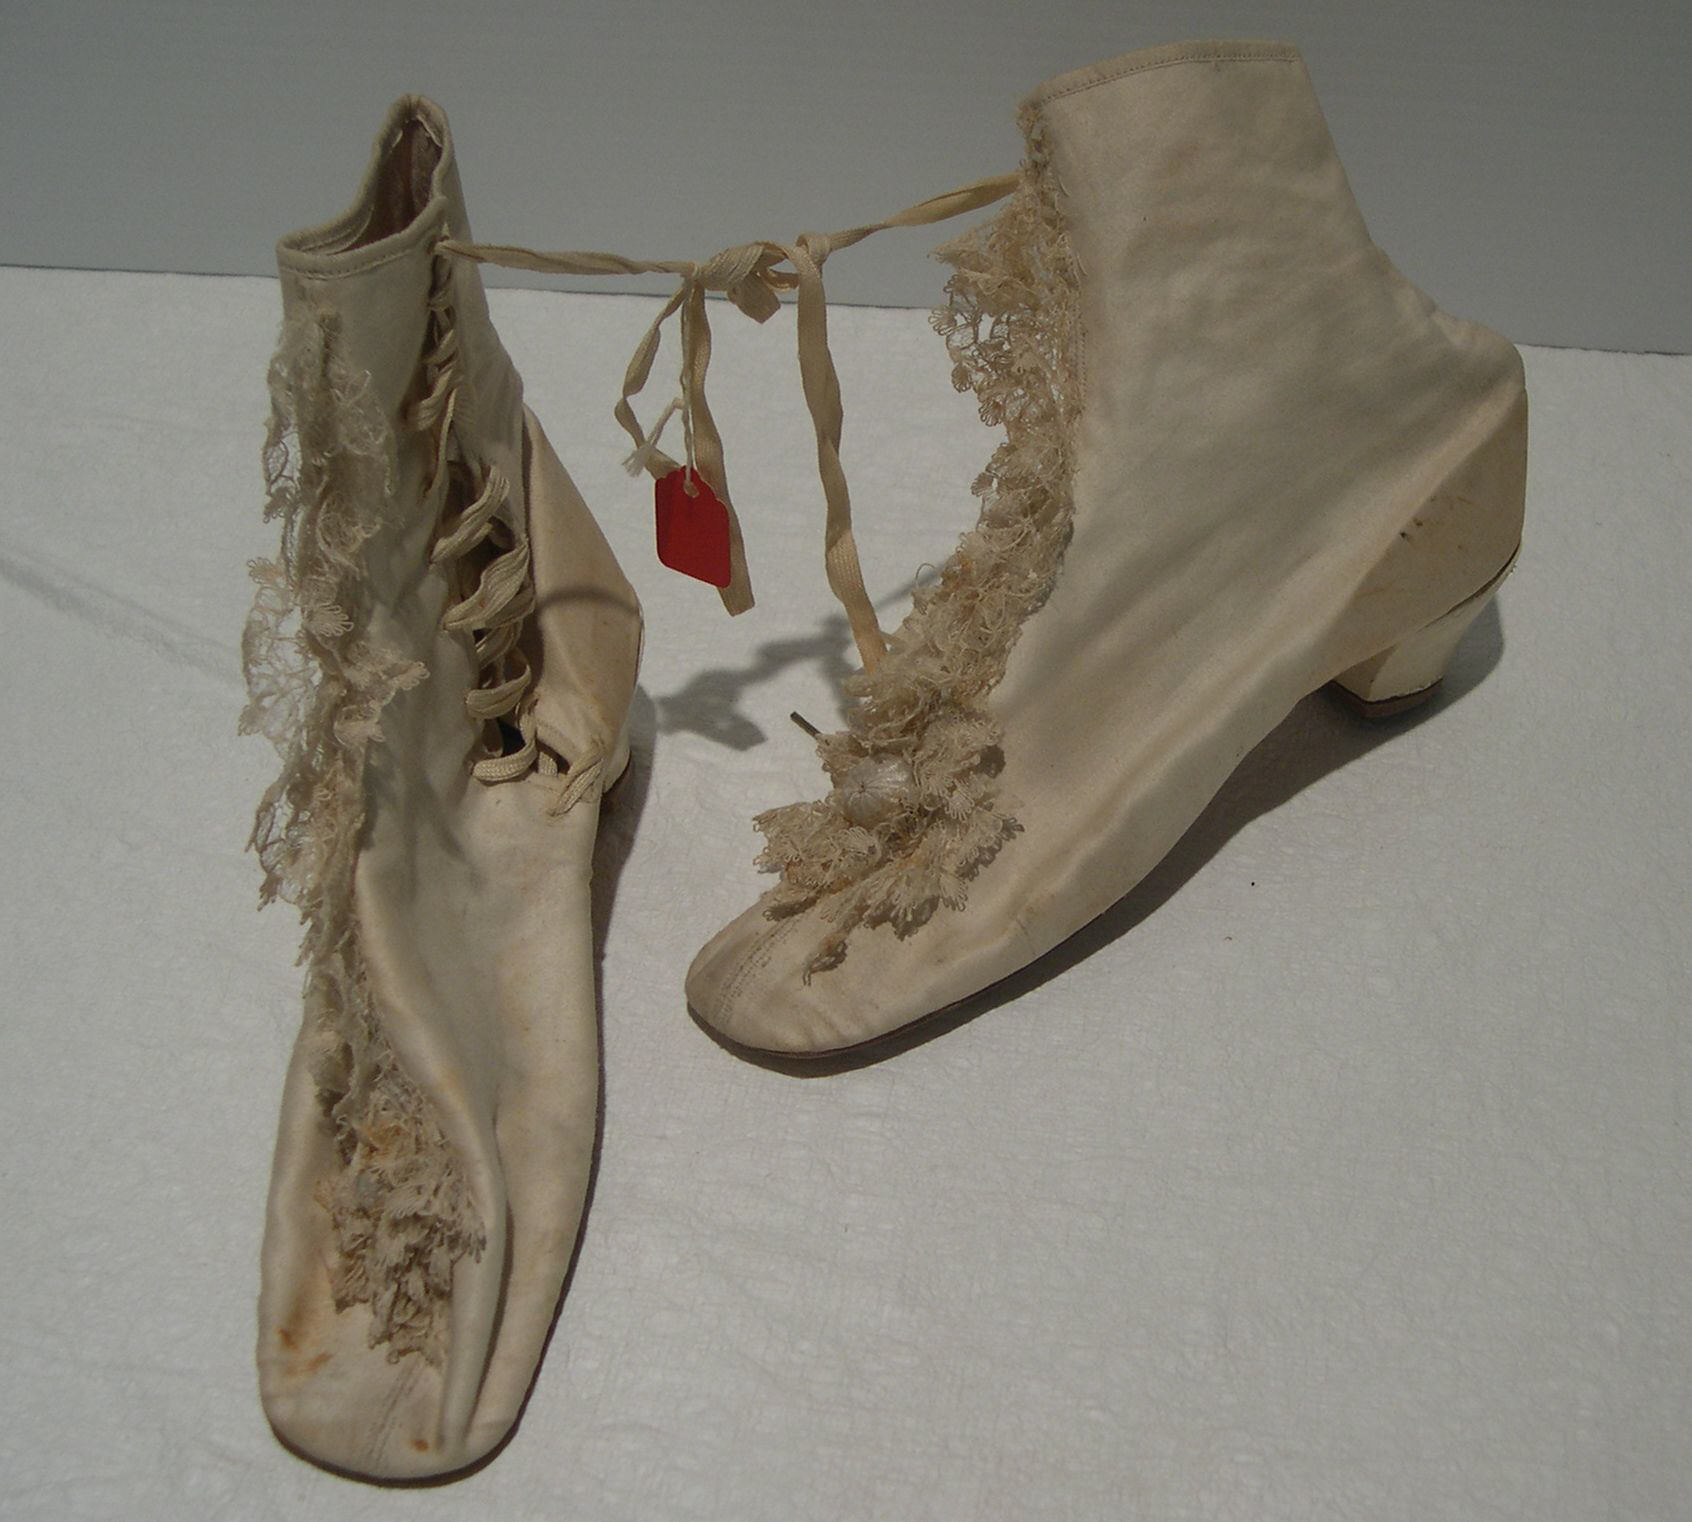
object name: boot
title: Boots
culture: american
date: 1860-1869